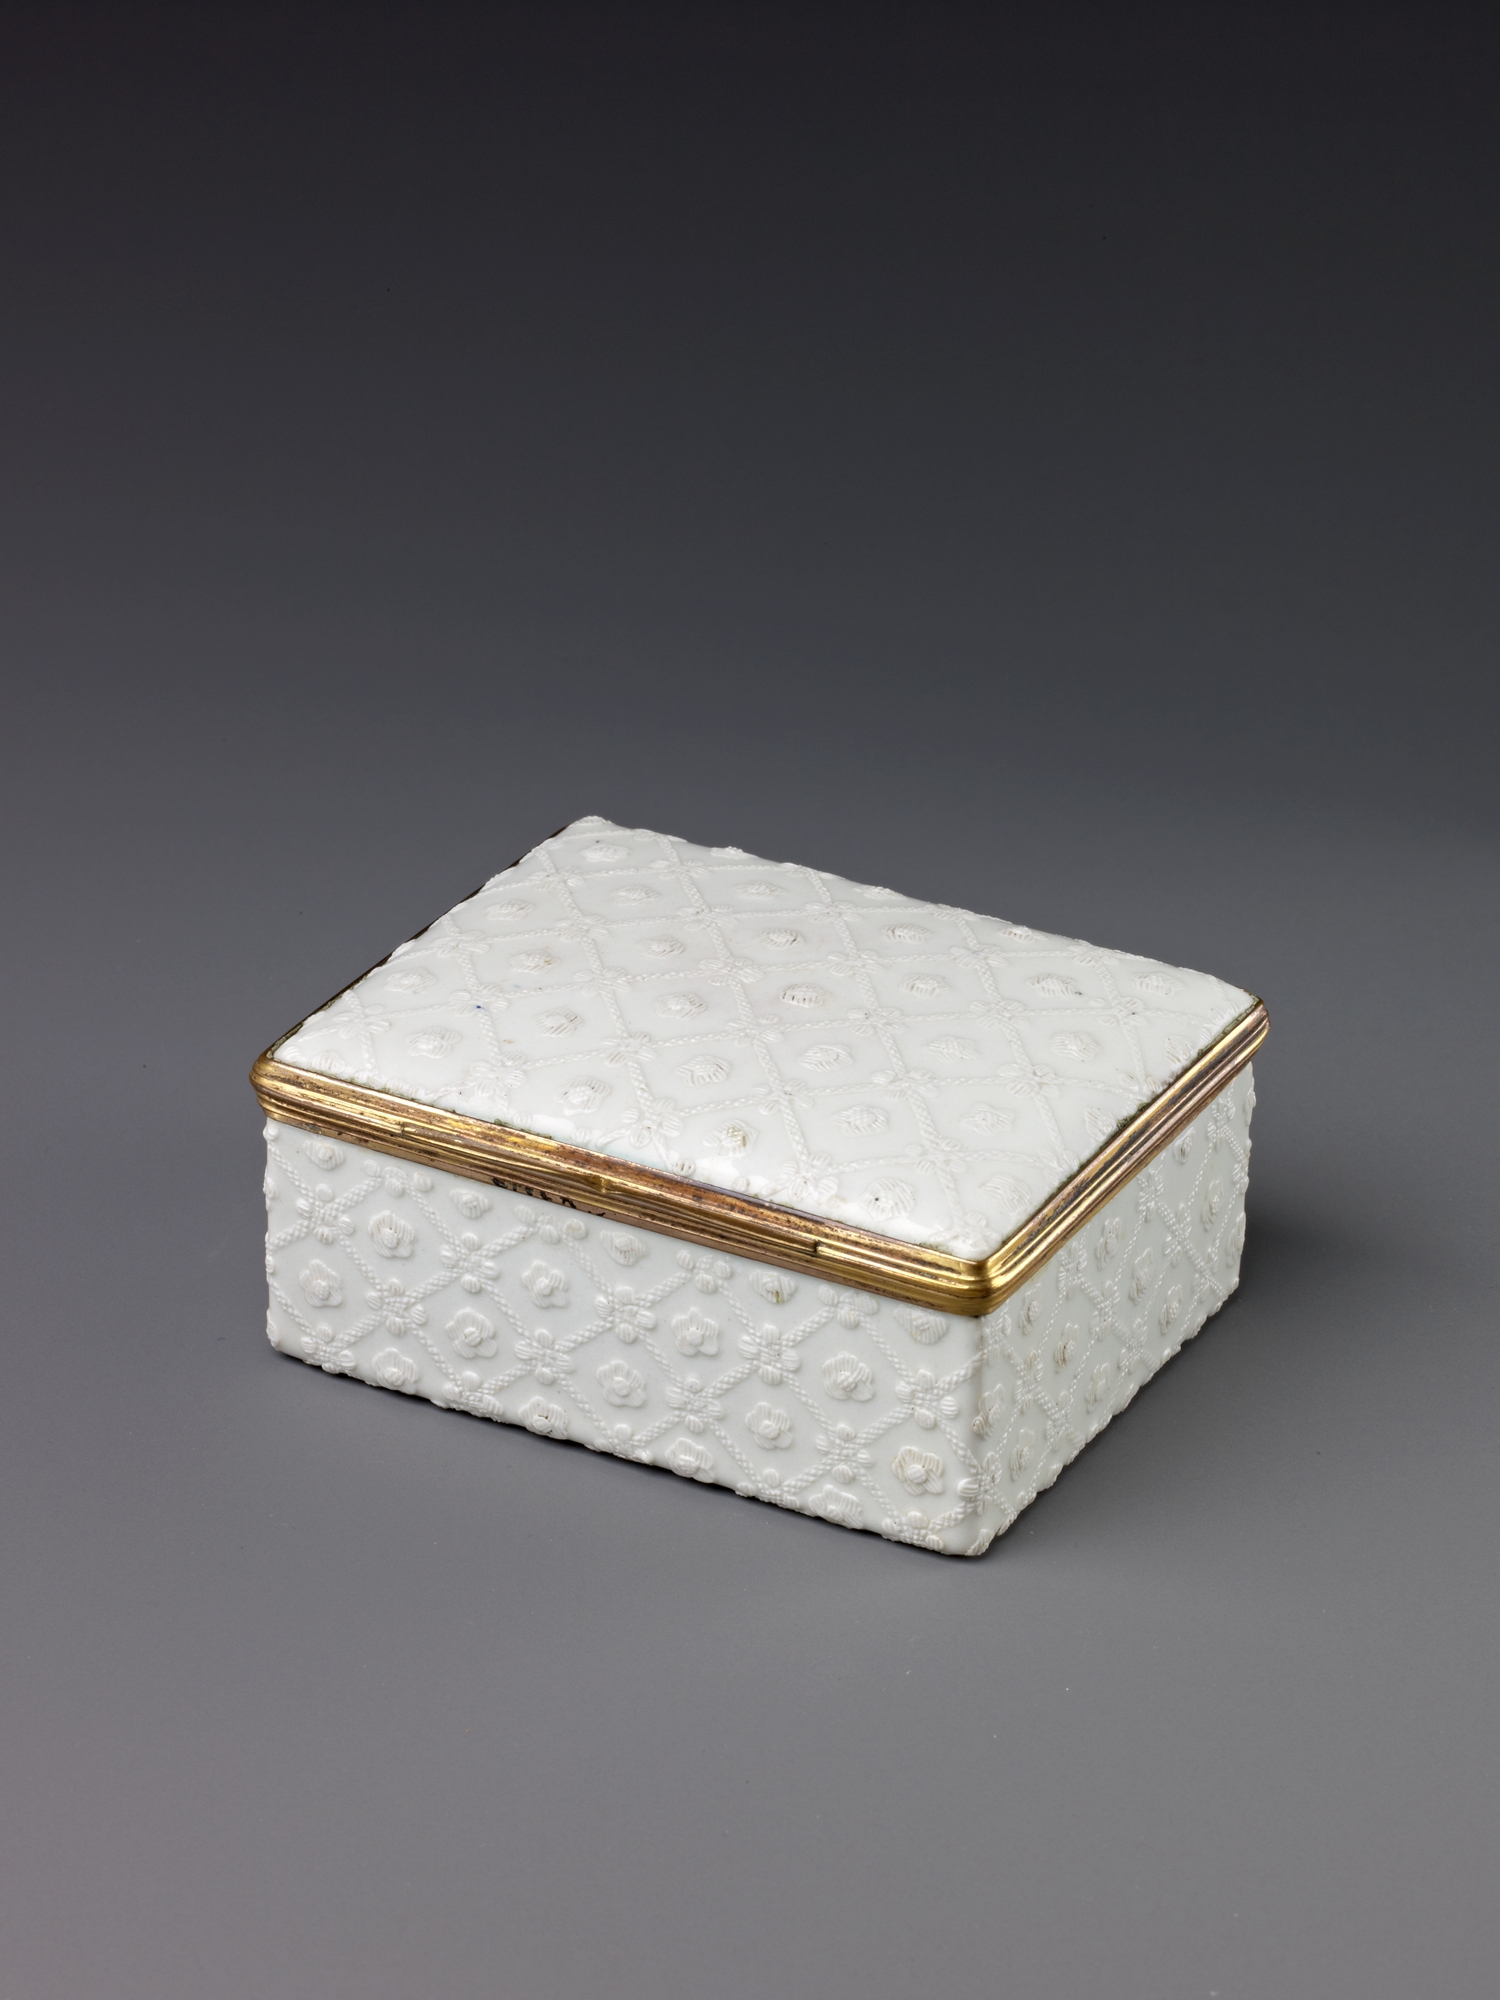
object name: snuffbox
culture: german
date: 1750-1760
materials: copper, gilt copper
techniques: enamel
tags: women,music